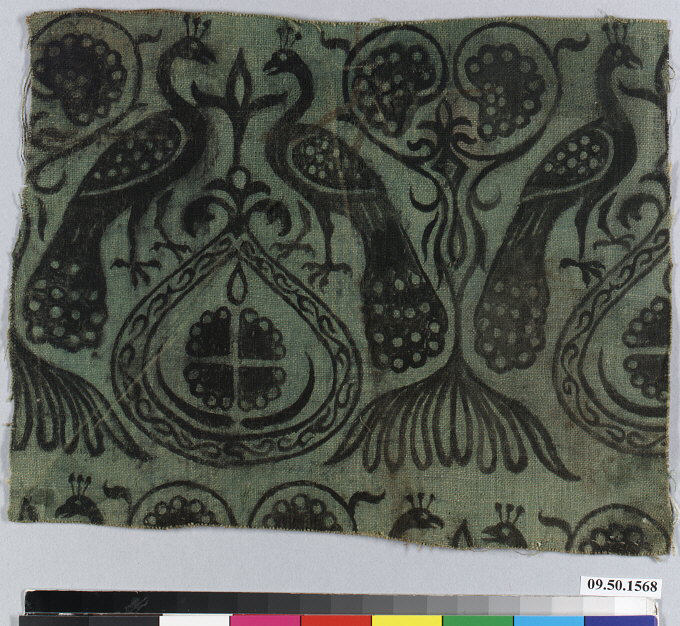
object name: fragment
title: Fragment reproducing 12th century design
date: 1801-1900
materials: linen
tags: peacocks